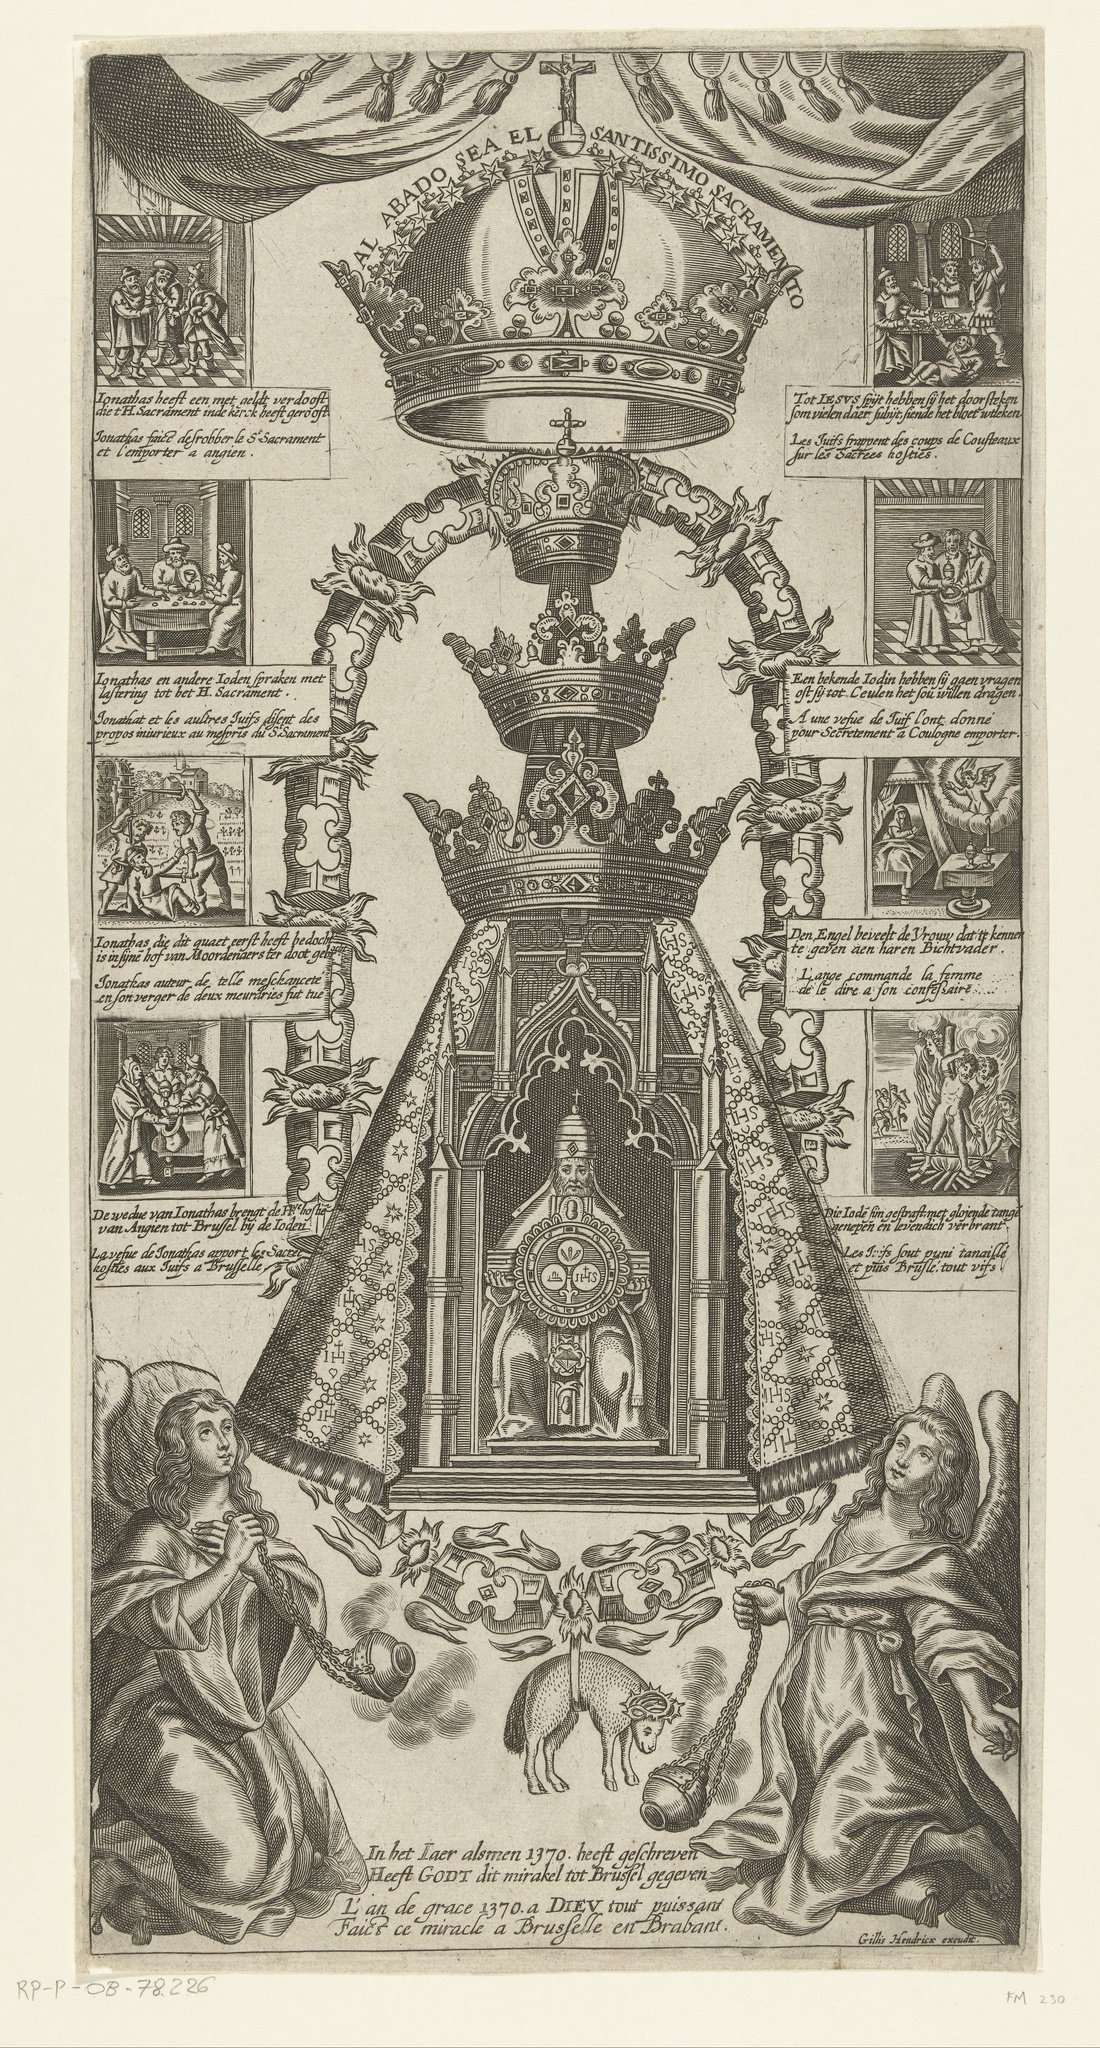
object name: print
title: Mirakel van het H. Sacrament te Brussel, 1370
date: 1718-1720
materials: paper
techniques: engraving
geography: southern netherlands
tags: relics (and reliquaries), knighthood order of the golden fleece, brussels, burgundian netherlands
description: Mirakel van het H. Sacrament te Brussel, 1370. Twee engelen aan weerszijden van een Mariamantel met vier kronen en ketting met het Gulden Vlies. In de mantel reliekhouder met God zittend achter het kruis waarop de miraculeuze hostie. Hieromheen wordt in acht kleine scènes het verhaal van het wonder verteld.